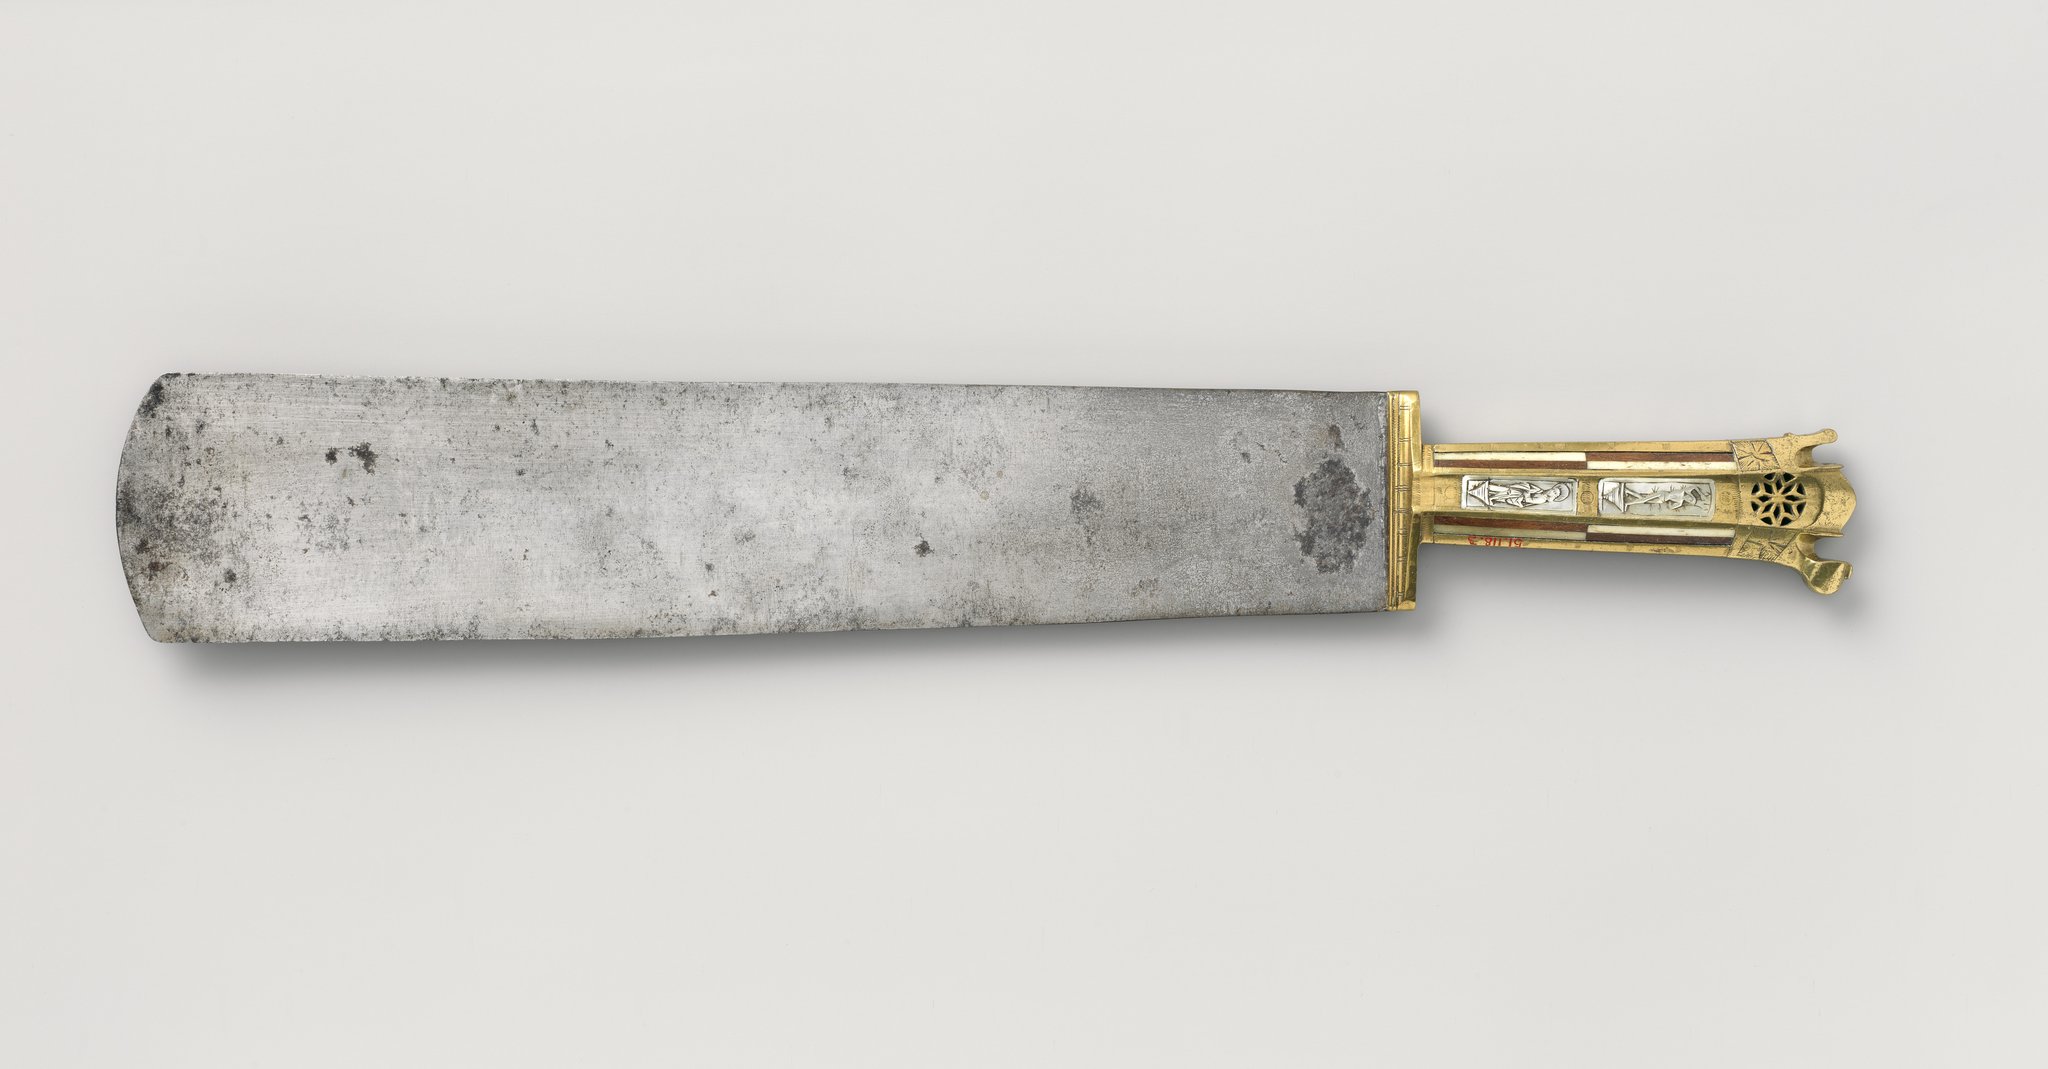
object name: knife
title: Serving Knife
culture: austrian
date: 1401-1600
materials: bone, brass, mother of pearl, steel, wood